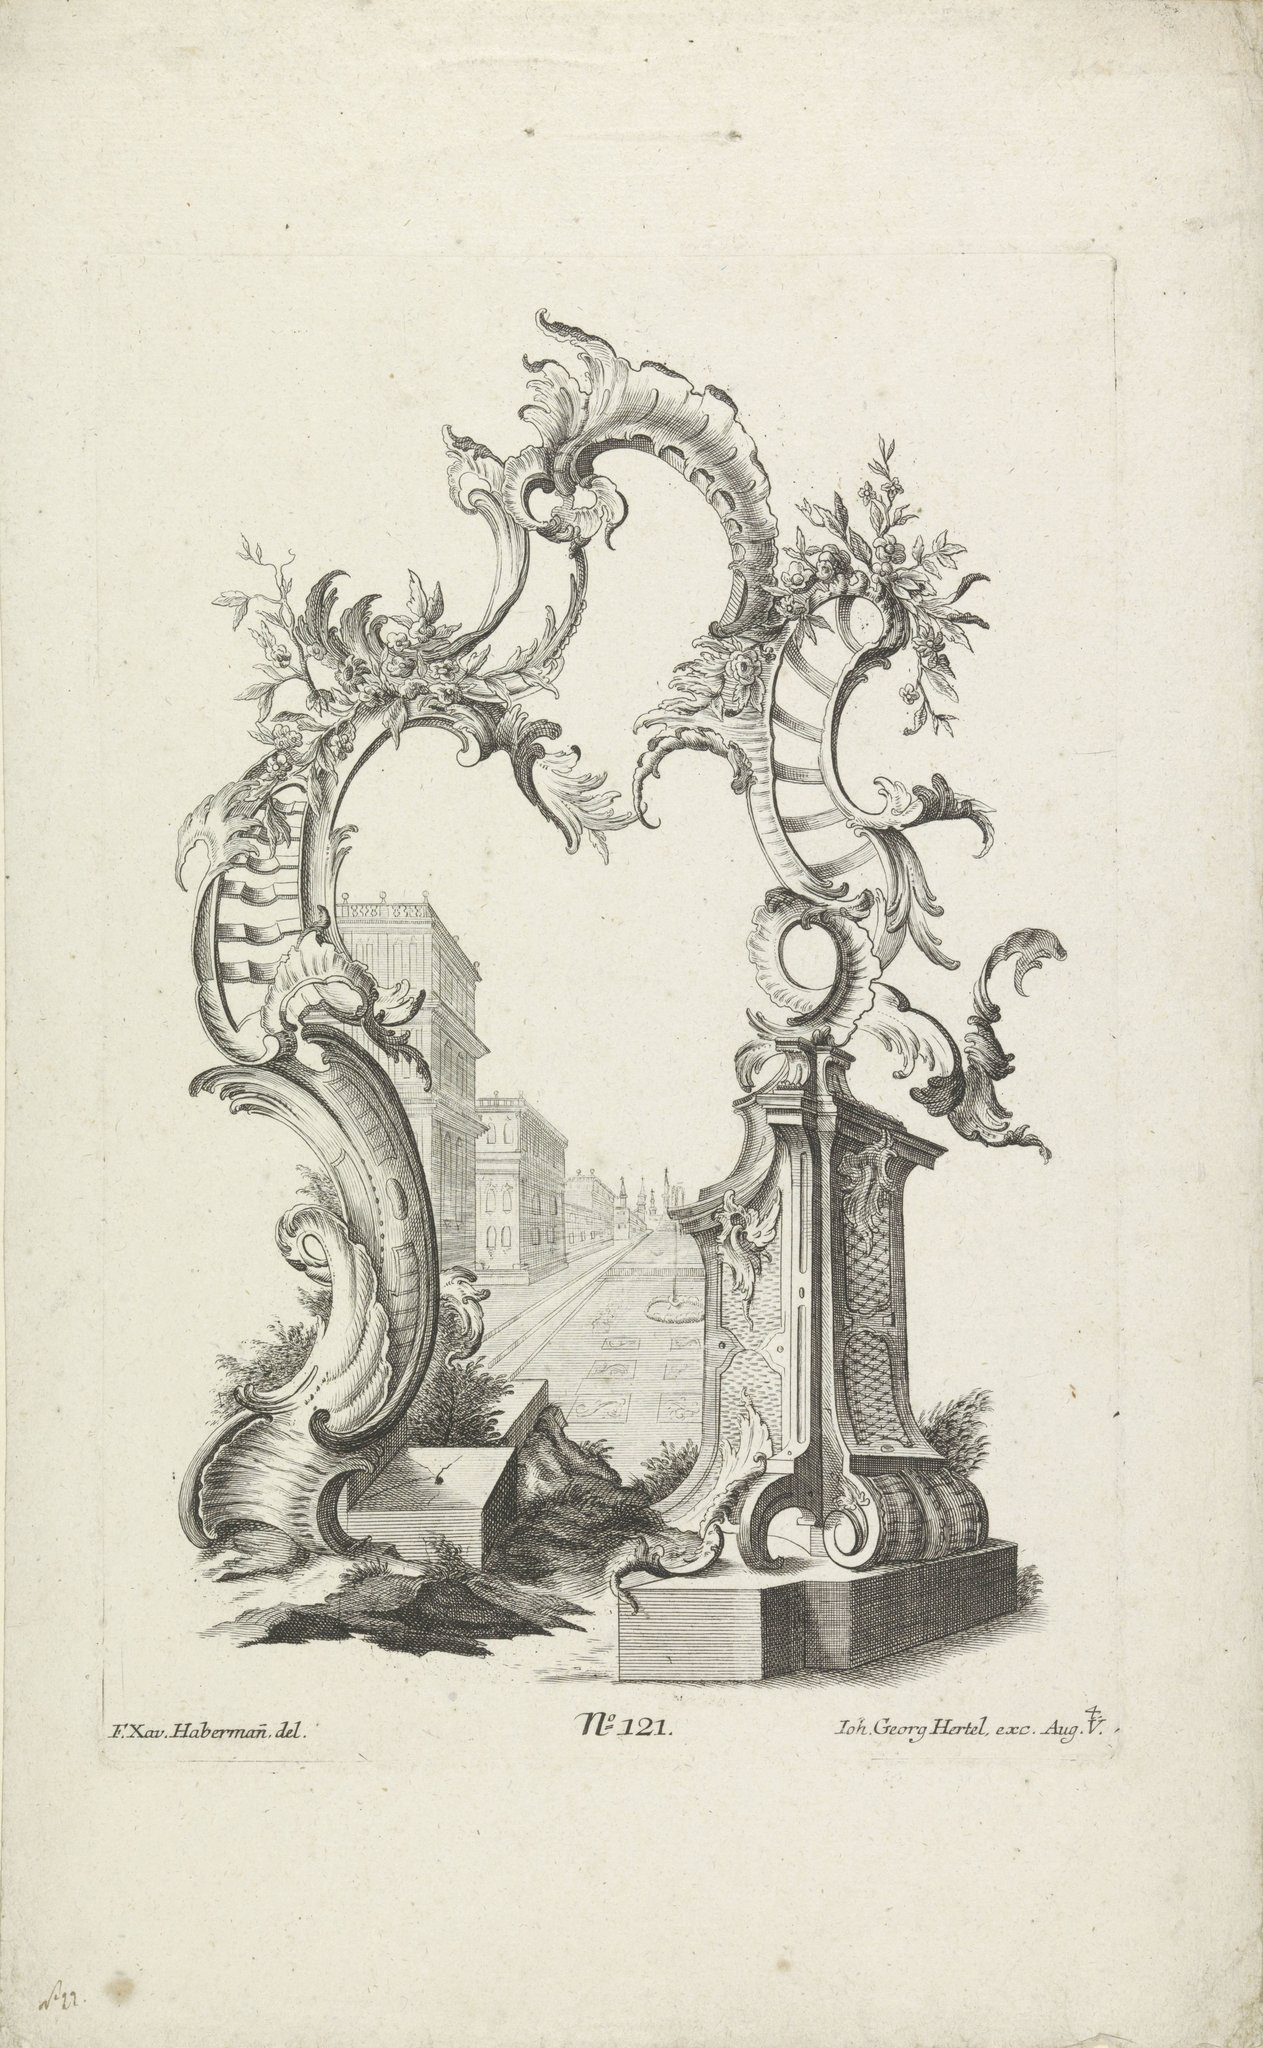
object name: ornament print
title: Tuinen in rocaille omlijsting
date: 1731-1775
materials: paper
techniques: etching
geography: augsburg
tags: park, rocaille ornament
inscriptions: collector's mark: Lugt 2760, collector's mark: Lugt 2228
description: Park met fontein naast gebouwen. In rocaille omlijsting. Uitgeversnummer 121.